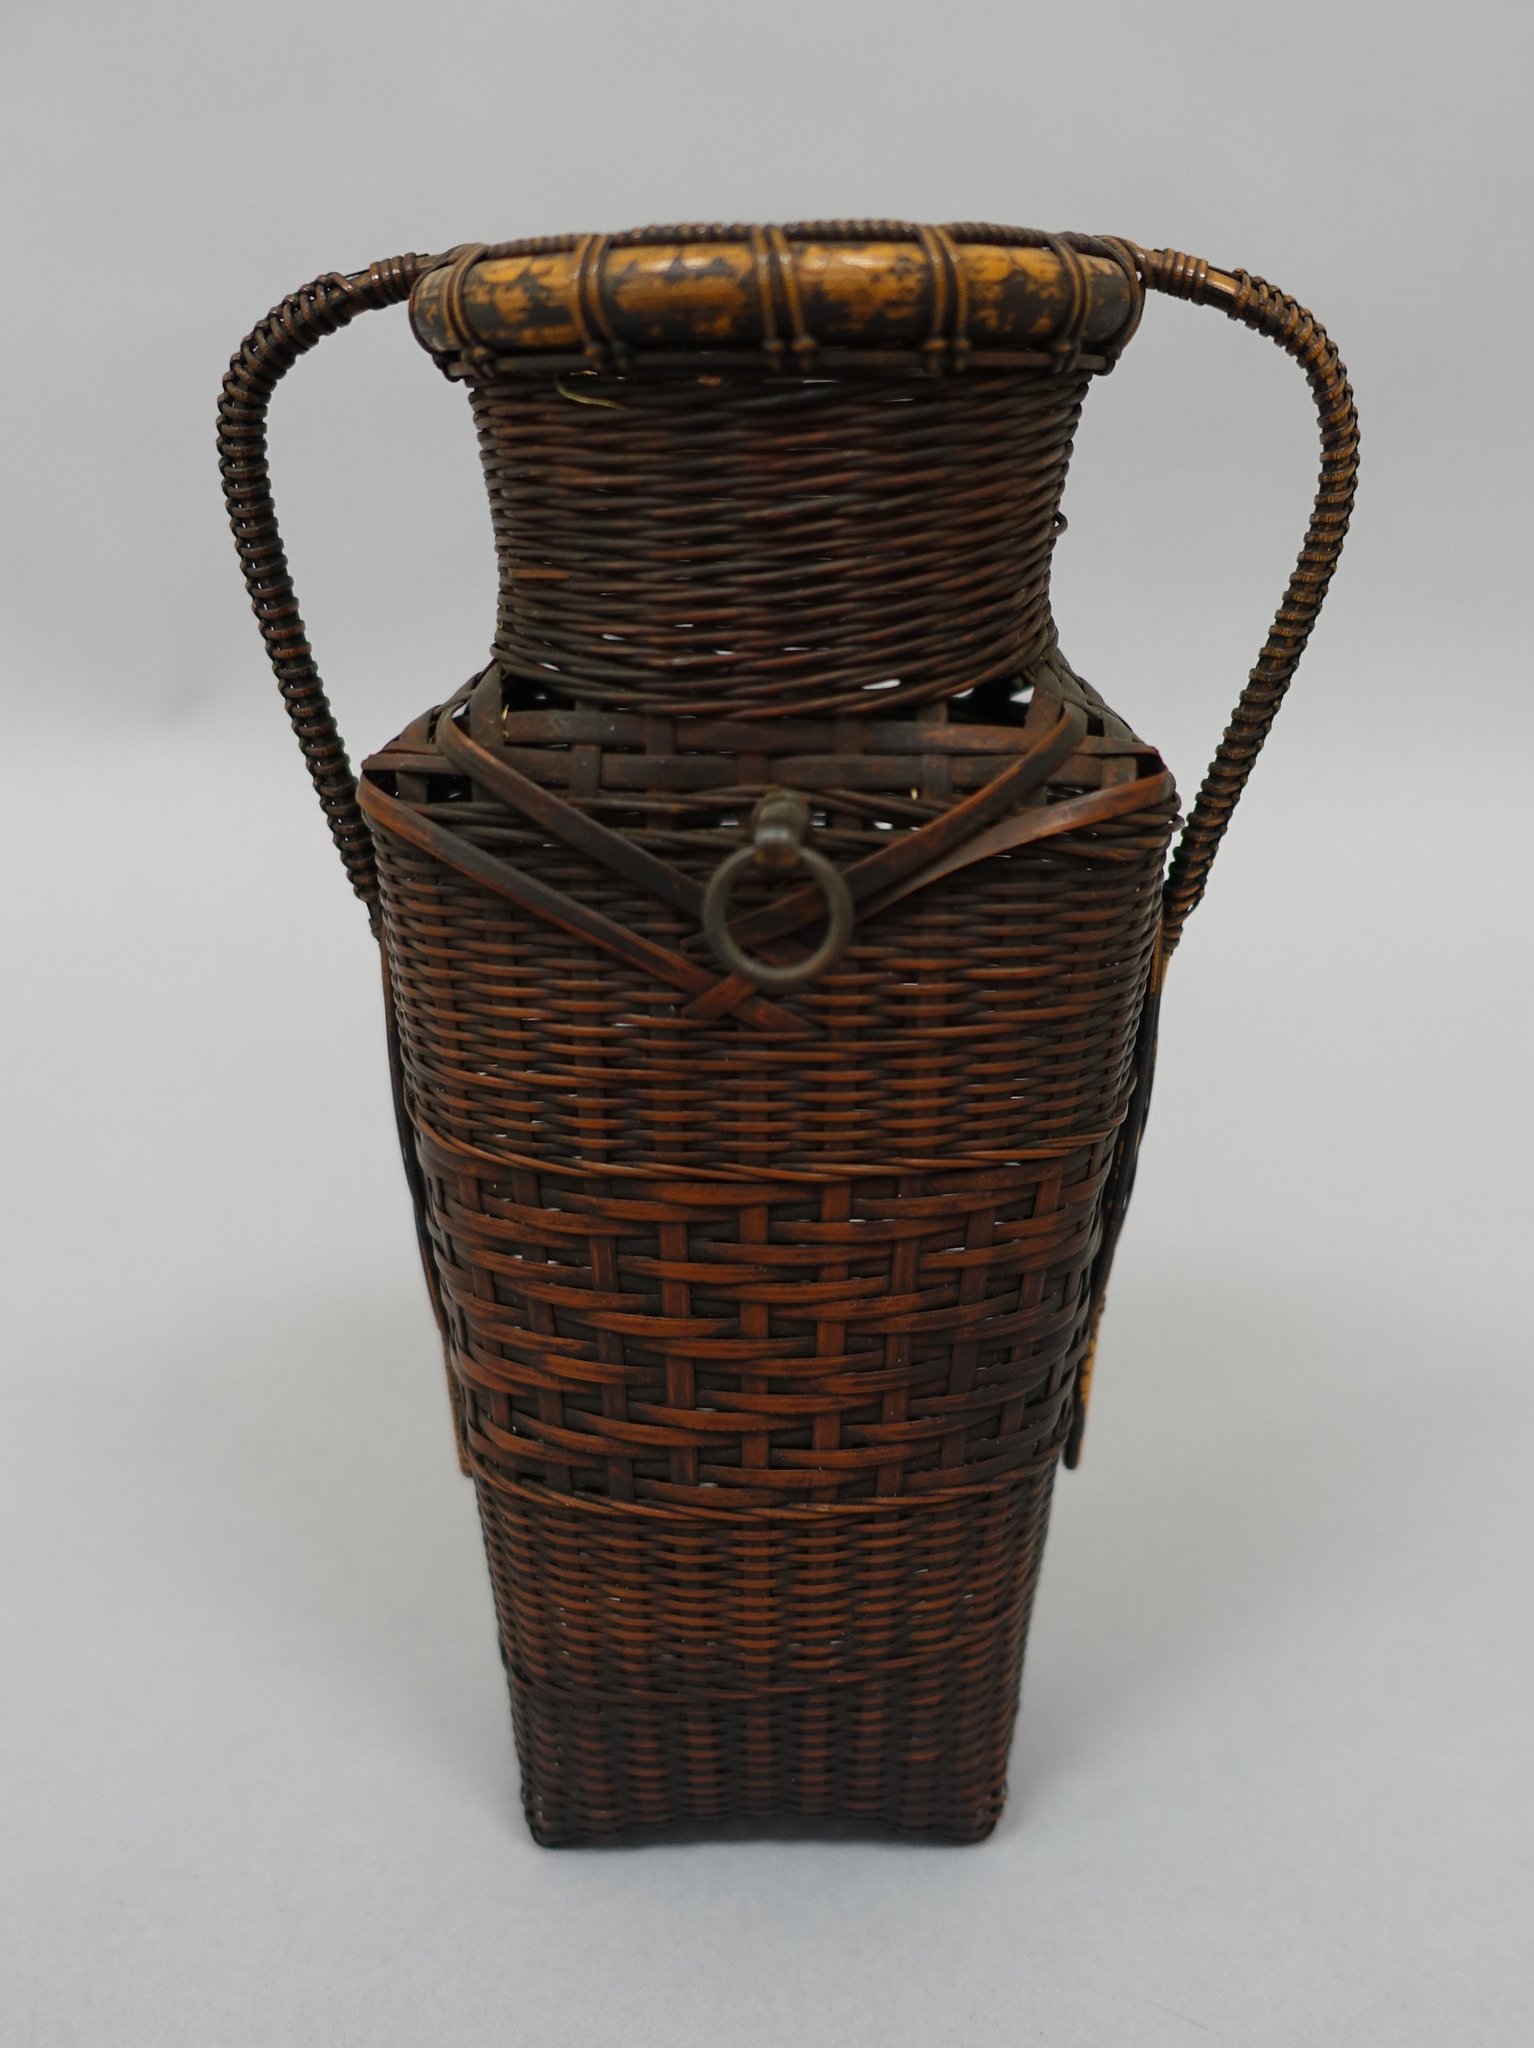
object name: hanging basket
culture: japanese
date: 1801-1900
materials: bamboo, rattan